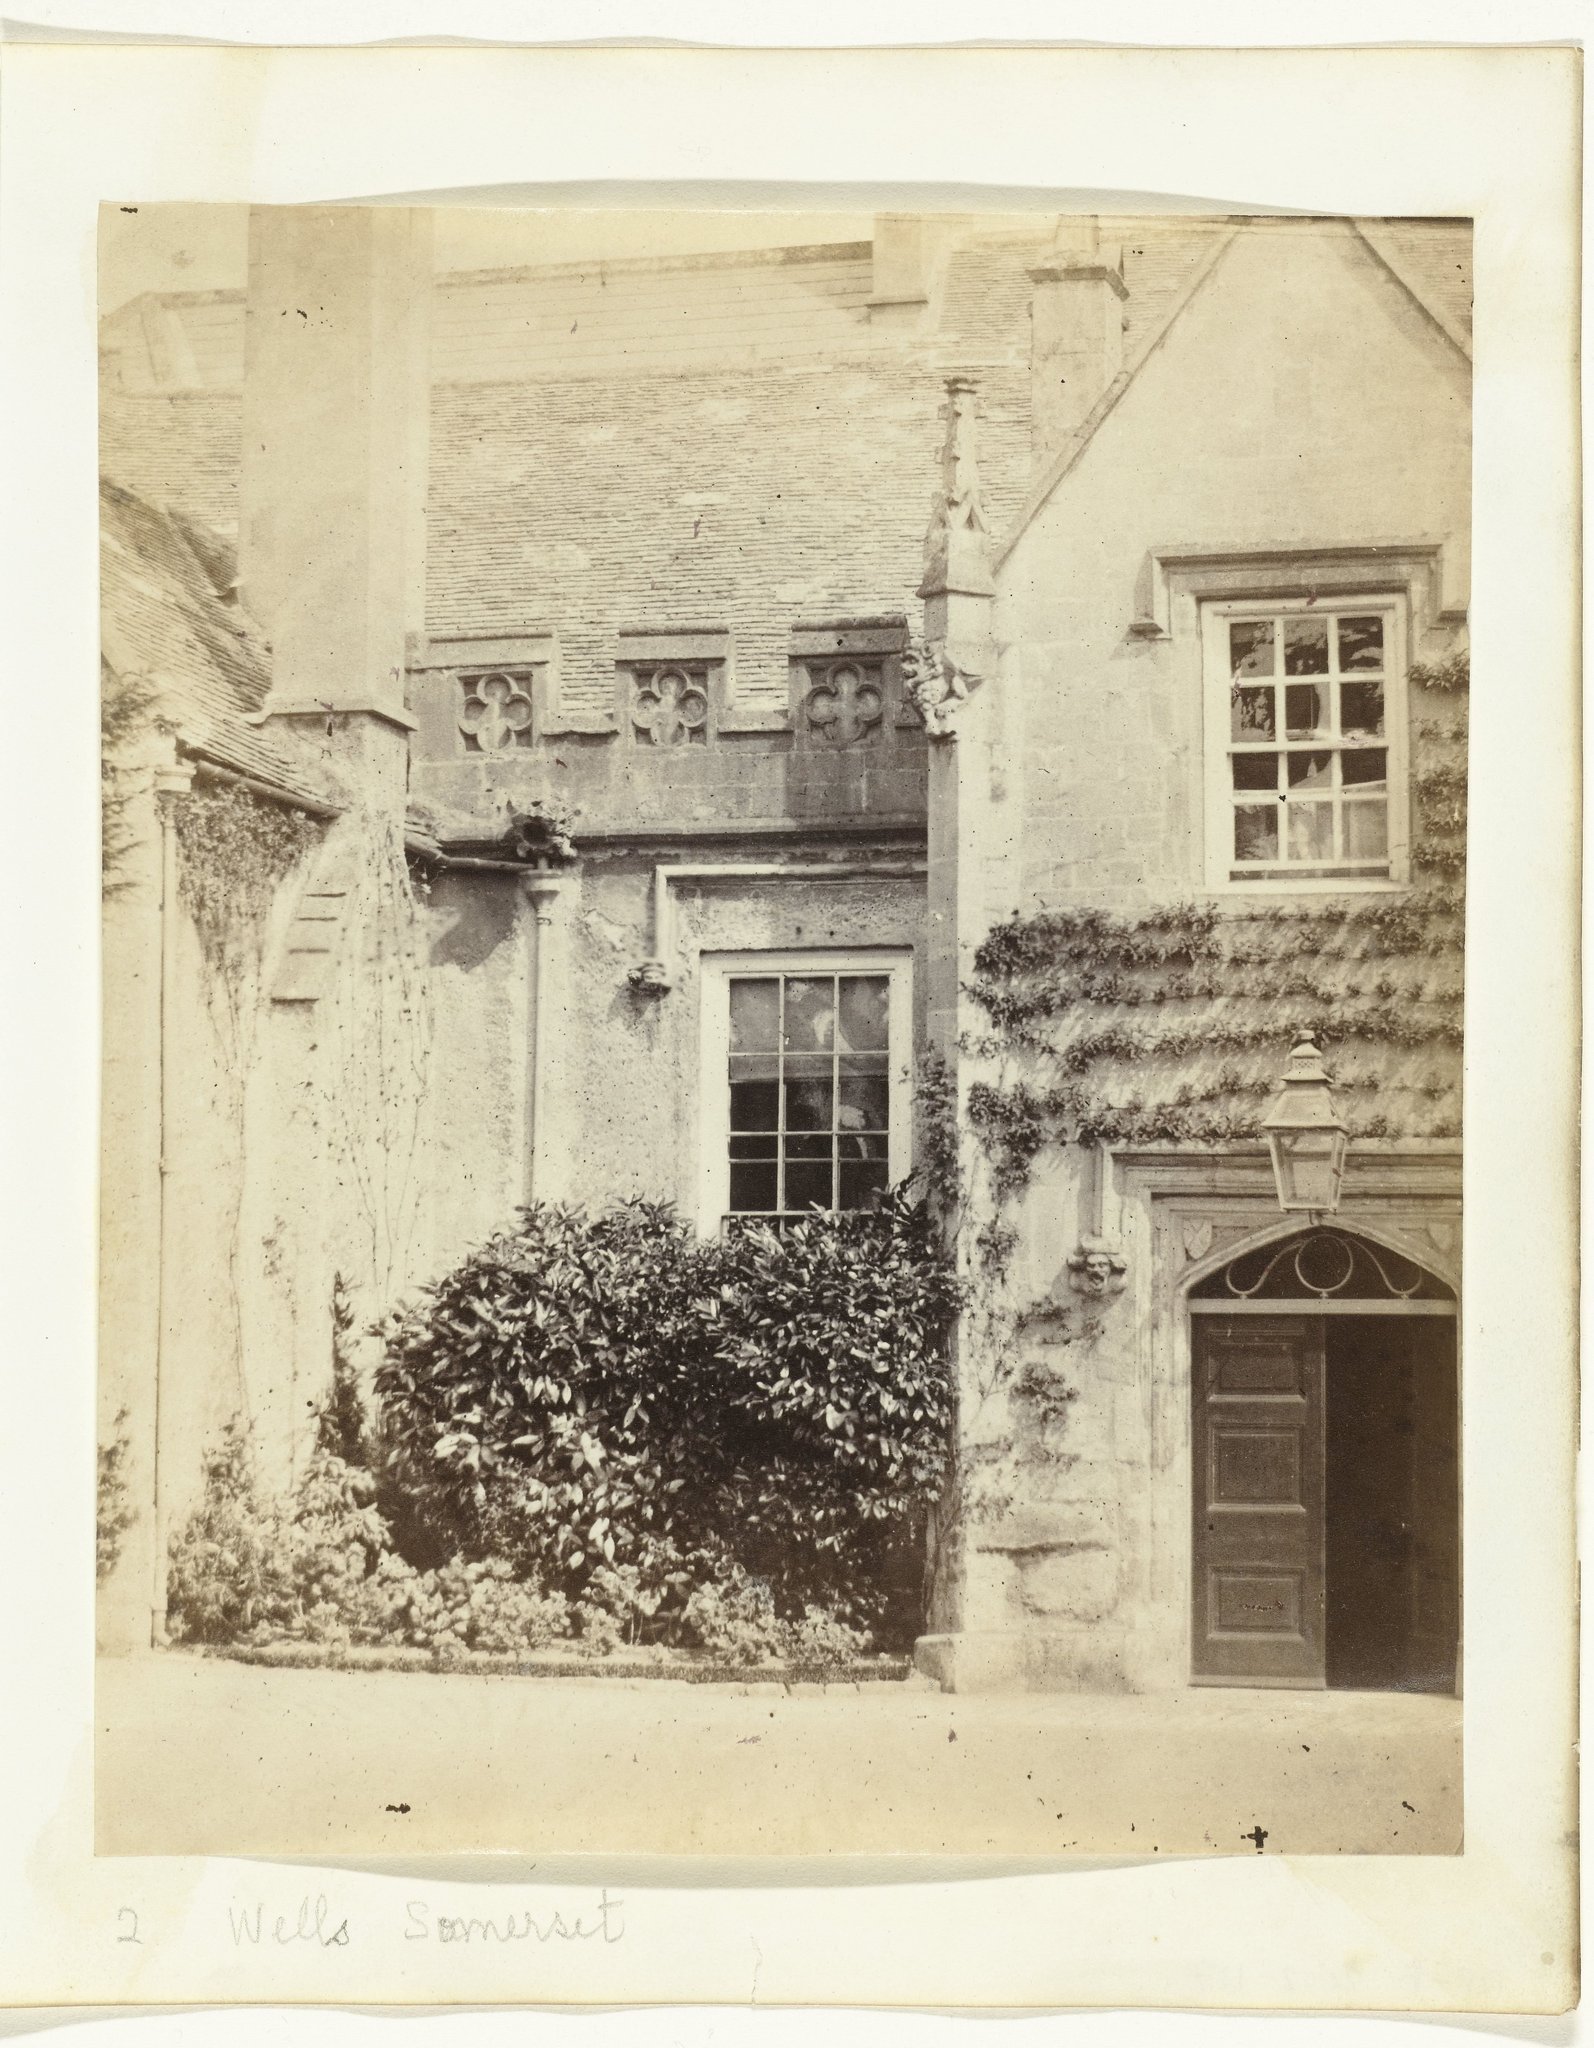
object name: photograph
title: Wells, Somerset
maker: Anonymous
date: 1851-1900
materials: paper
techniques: albumen print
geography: wells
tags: façade (of house or building)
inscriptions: number: ‘2’